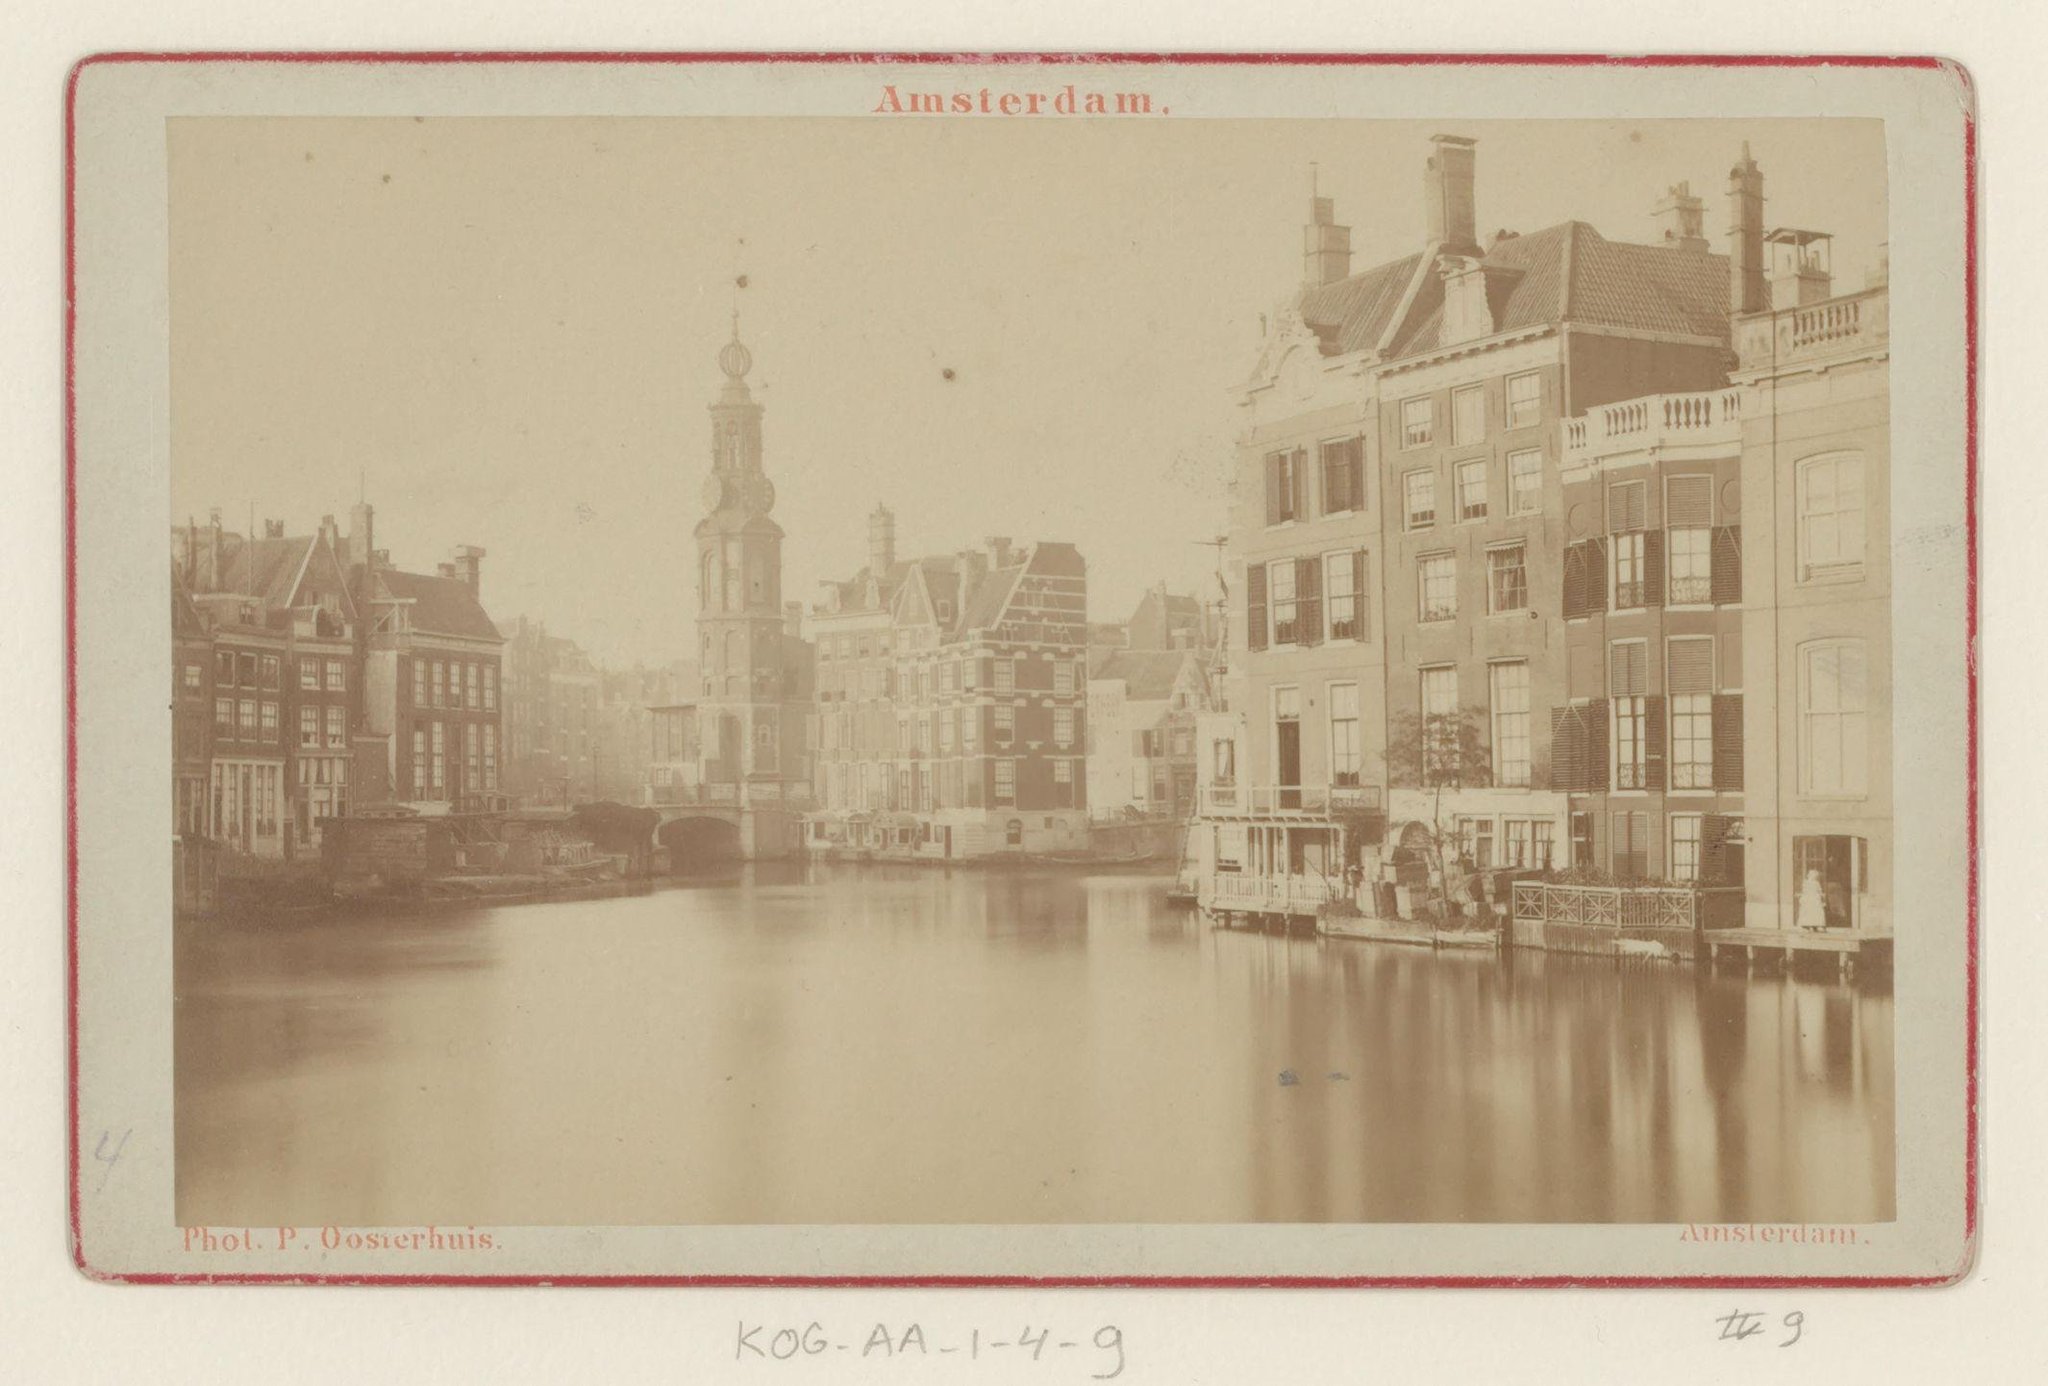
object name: cabinet photograph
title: Gezicht op de Binnen-Amstel en het Muntplein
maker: pieter oosterhuis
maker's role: draughtsman, print maker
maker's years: 1816-1885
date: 1826-1885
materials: cardboard, paper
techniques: albumen print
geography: amsterdam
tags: tower, clock tower ~ monumental adornment, city-view in general; 'veduta', canal, bridge in city across river, canal, etc.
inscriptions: collector's mark: ‘4’ Lugt 1641b, inscription: ‘H hoog / [...]ogg3 zn / 11 hoog (?)’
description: Onderwerpsrubriek binnen de Atlas Amsterdam: Amstel van Doelensluis tot Blauwbrug.